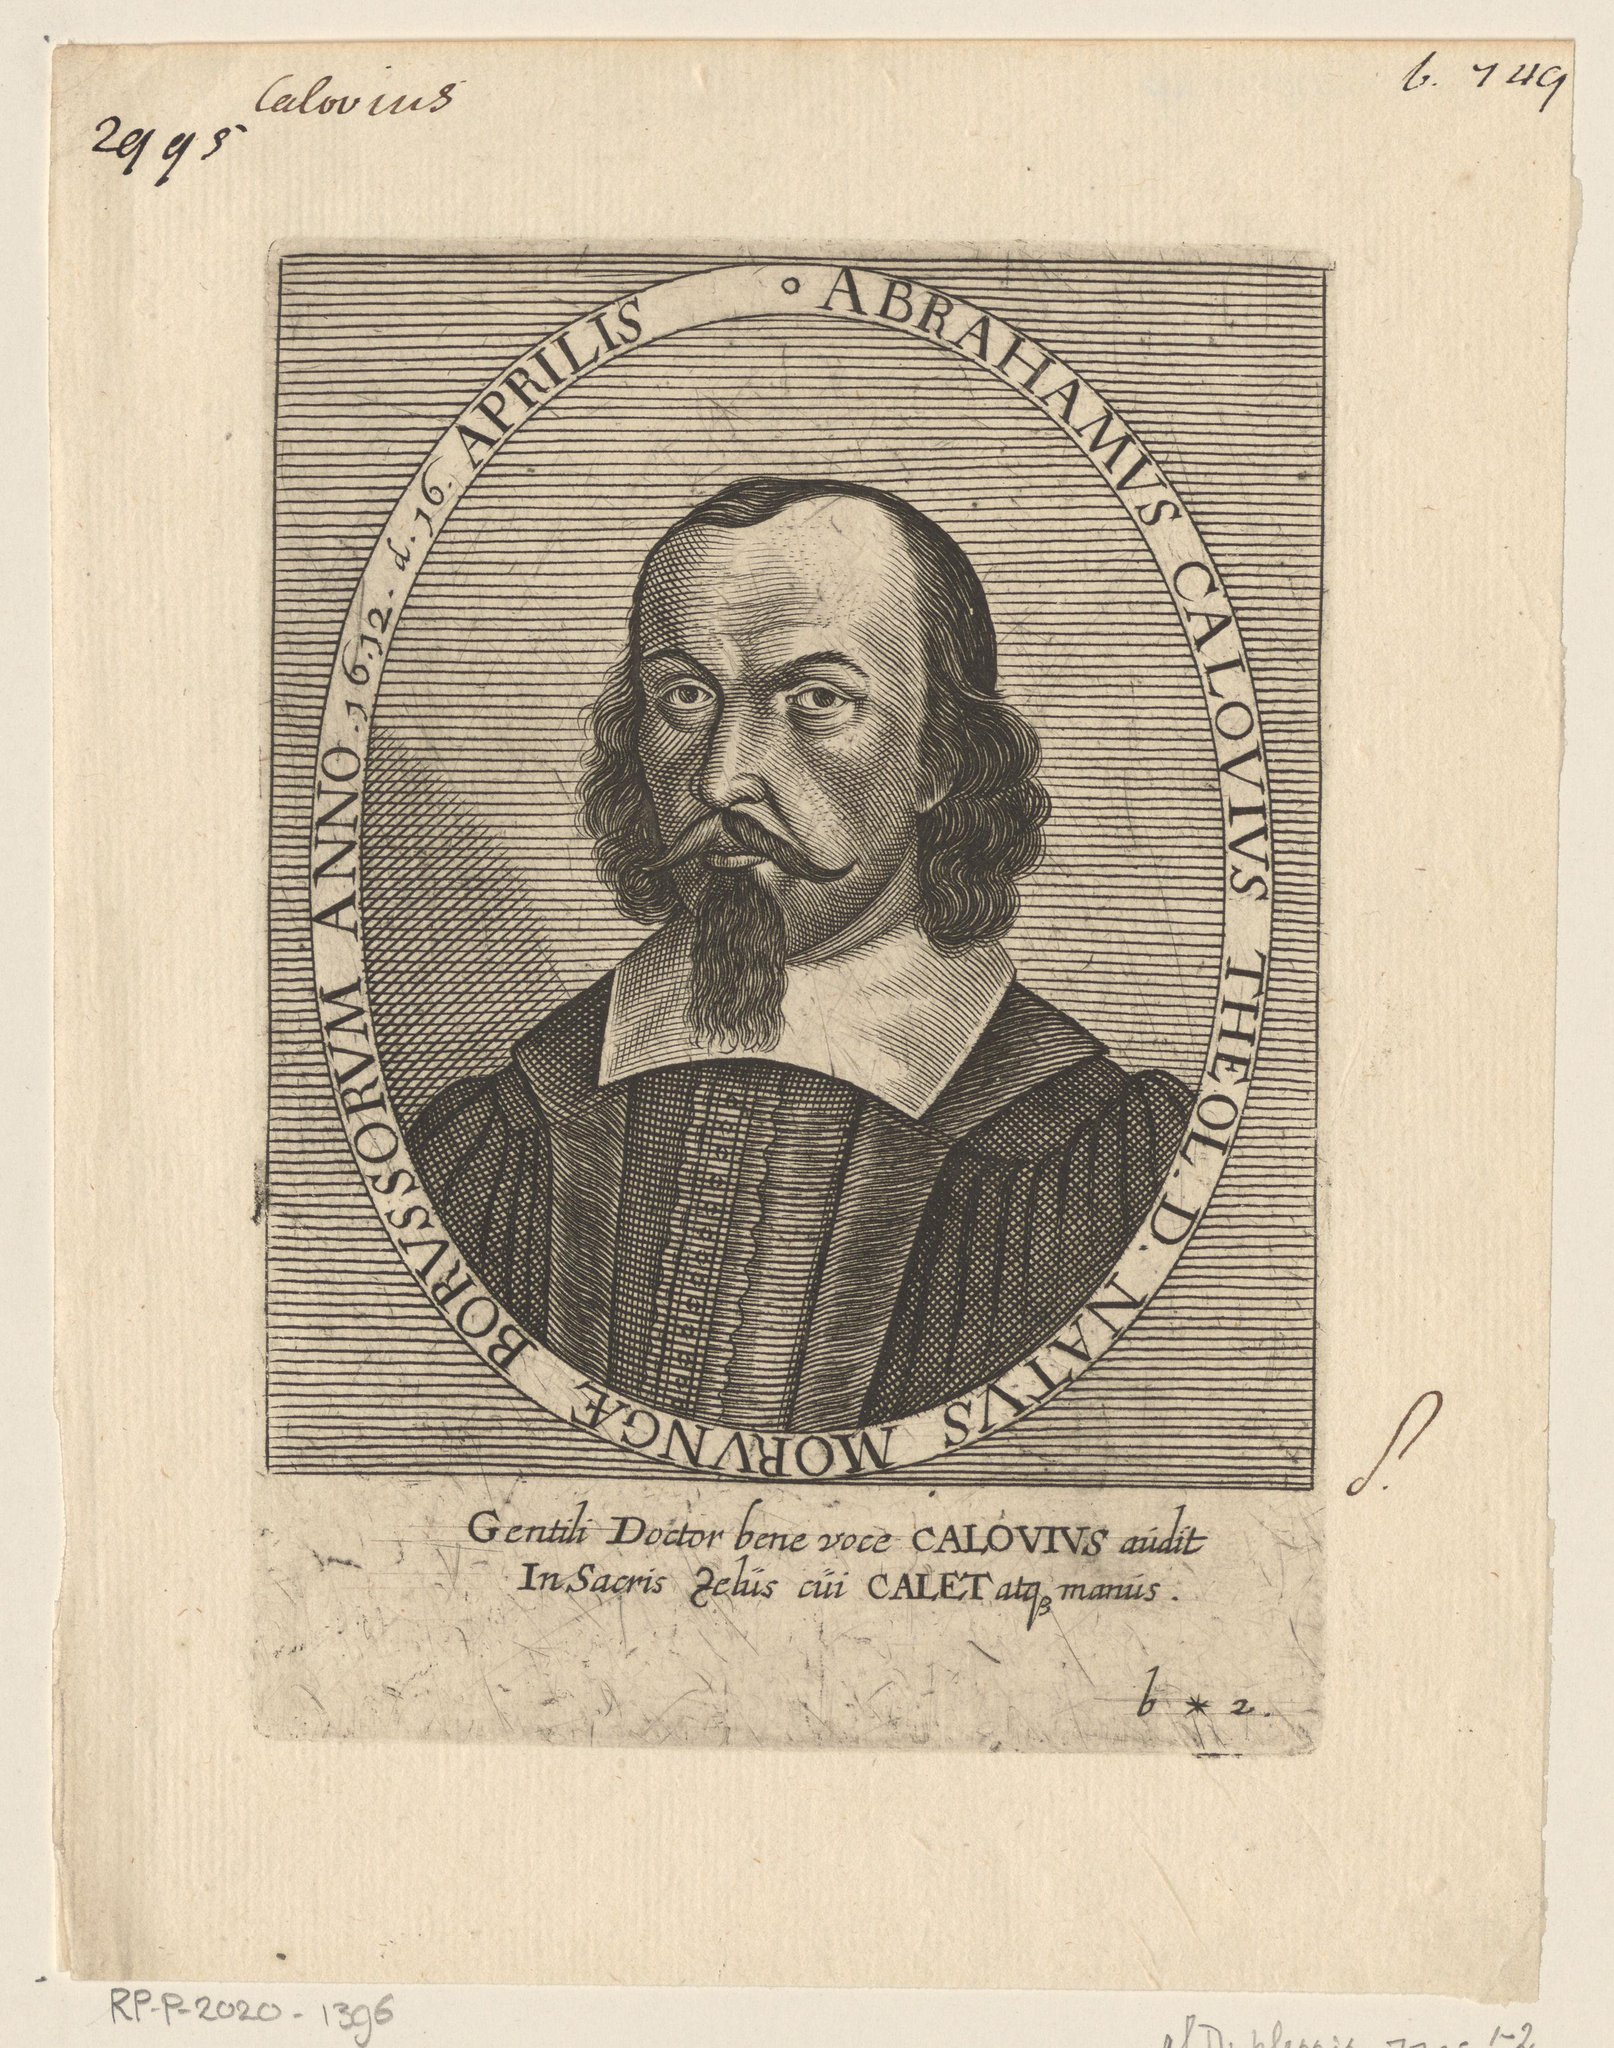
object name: print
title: Portret van Abraham Calovius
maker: Anonymous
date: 1664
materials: paper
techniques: engraving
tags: historical persons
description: Prent ook gebruikt in: Boissard, Jean Jacques. Bibliotheca Chalcographica (...). 9 dln. Heidelberg: Clemens Ammon, 1664.